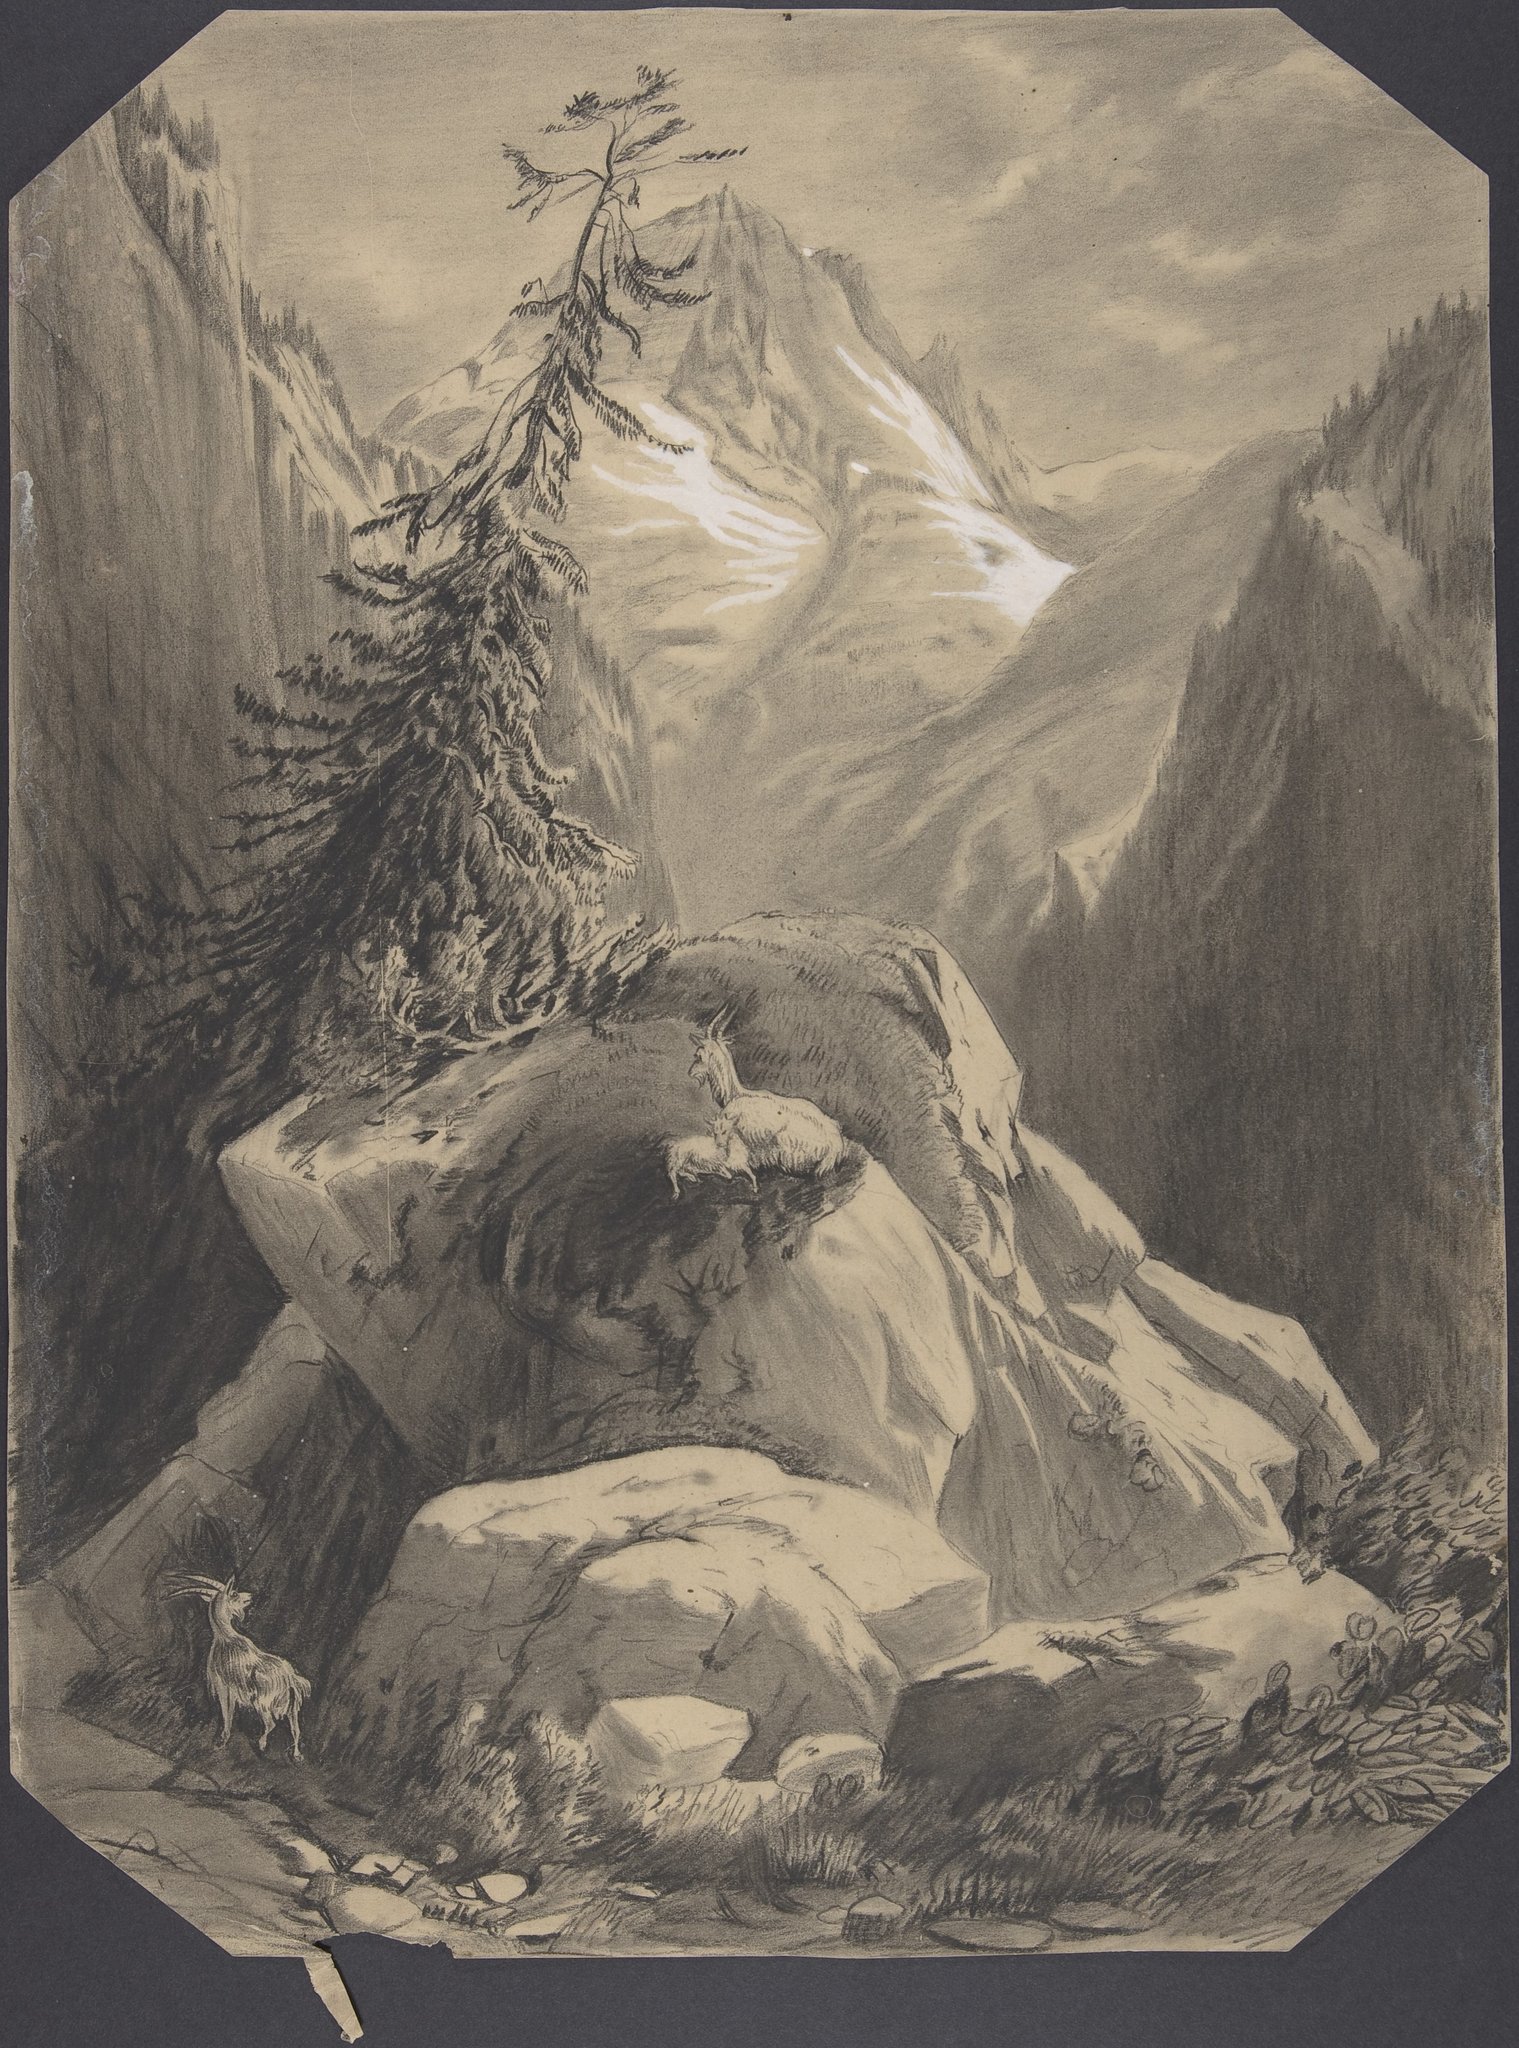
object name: drawing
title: Three Goats in a Moutainous Landscape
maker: alexandre calame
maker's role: artist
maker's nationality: swiss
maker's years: 1810-1864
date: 1830-1864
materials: paint, chalk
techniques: cutting, heightening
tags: goats,mountains,landscapes,trees